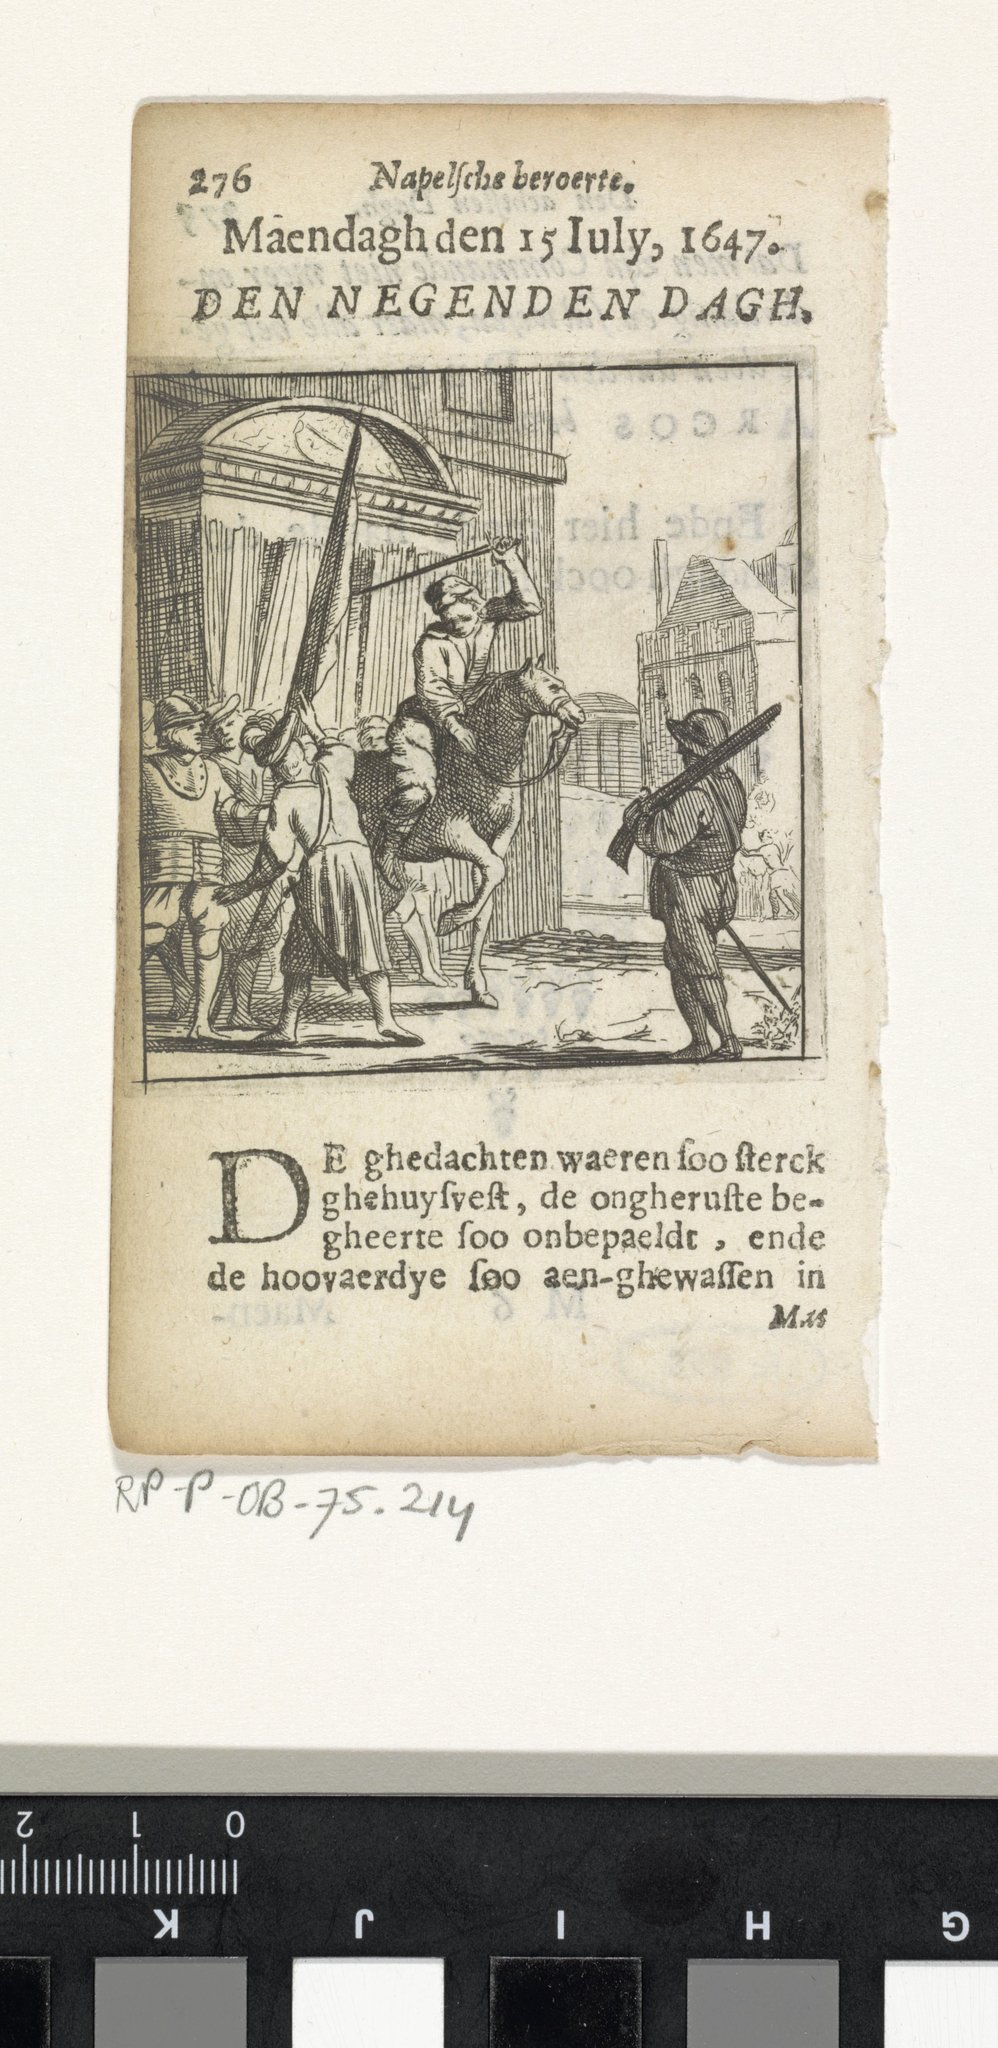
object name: book illustration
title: Gebeurtenis op 15 juli 1647 tijdens de Napolitaanse opstand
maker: Anonymous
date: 1652-1664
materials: paper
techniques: engraving, etching, letterpress printing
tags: riding a horse, ass, or mule; rider, horseman, naples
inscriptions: collector's mark: Lugt 2228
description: Prent uit een van de uitgaven van: Giraffi, Alessandro. Het eerste deel der Napelsche beroerte. [Vertaald uit het Italiaans door] Lambert van den Bos. 1652-1664.